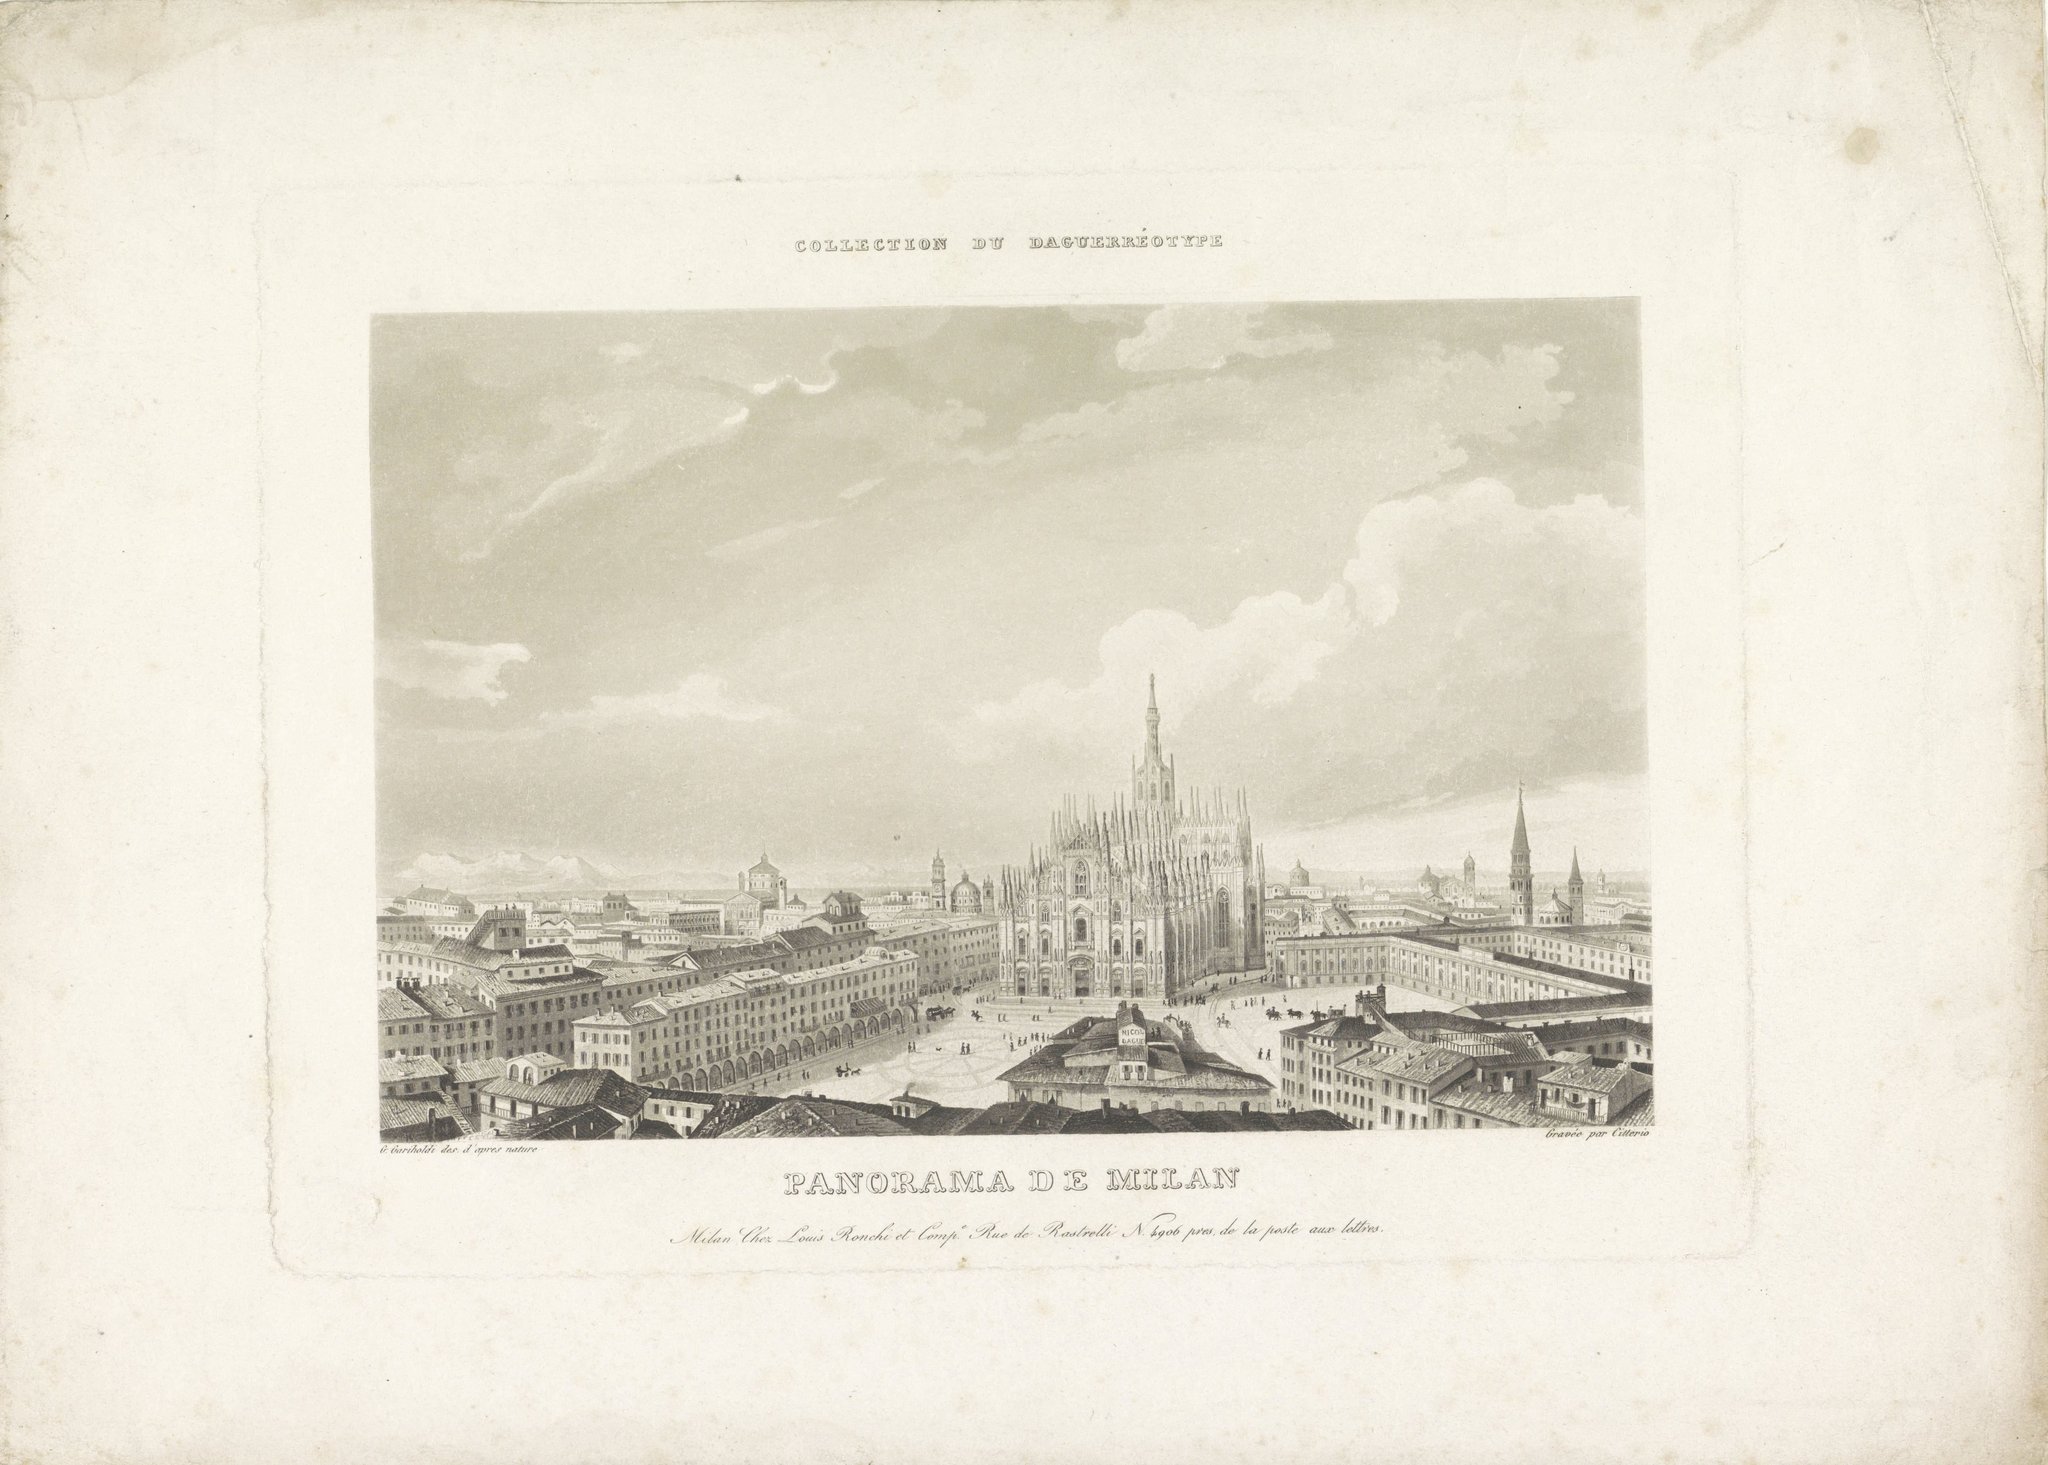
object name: print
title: Gezicht op Milaan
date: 1800-1899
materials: paper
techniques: aquatint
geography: italy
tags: square, place, circus, etc., city-view in general; 'veduta', church (exterior)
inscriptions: collector's mark: Lugt 2228, collector's mark: ‘L.R.C.’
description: Een gezicht op Milaan, met de Dom, het Piazza del Duomo, de Galleria Vittorio Emanuele en het Palazzo Reale.